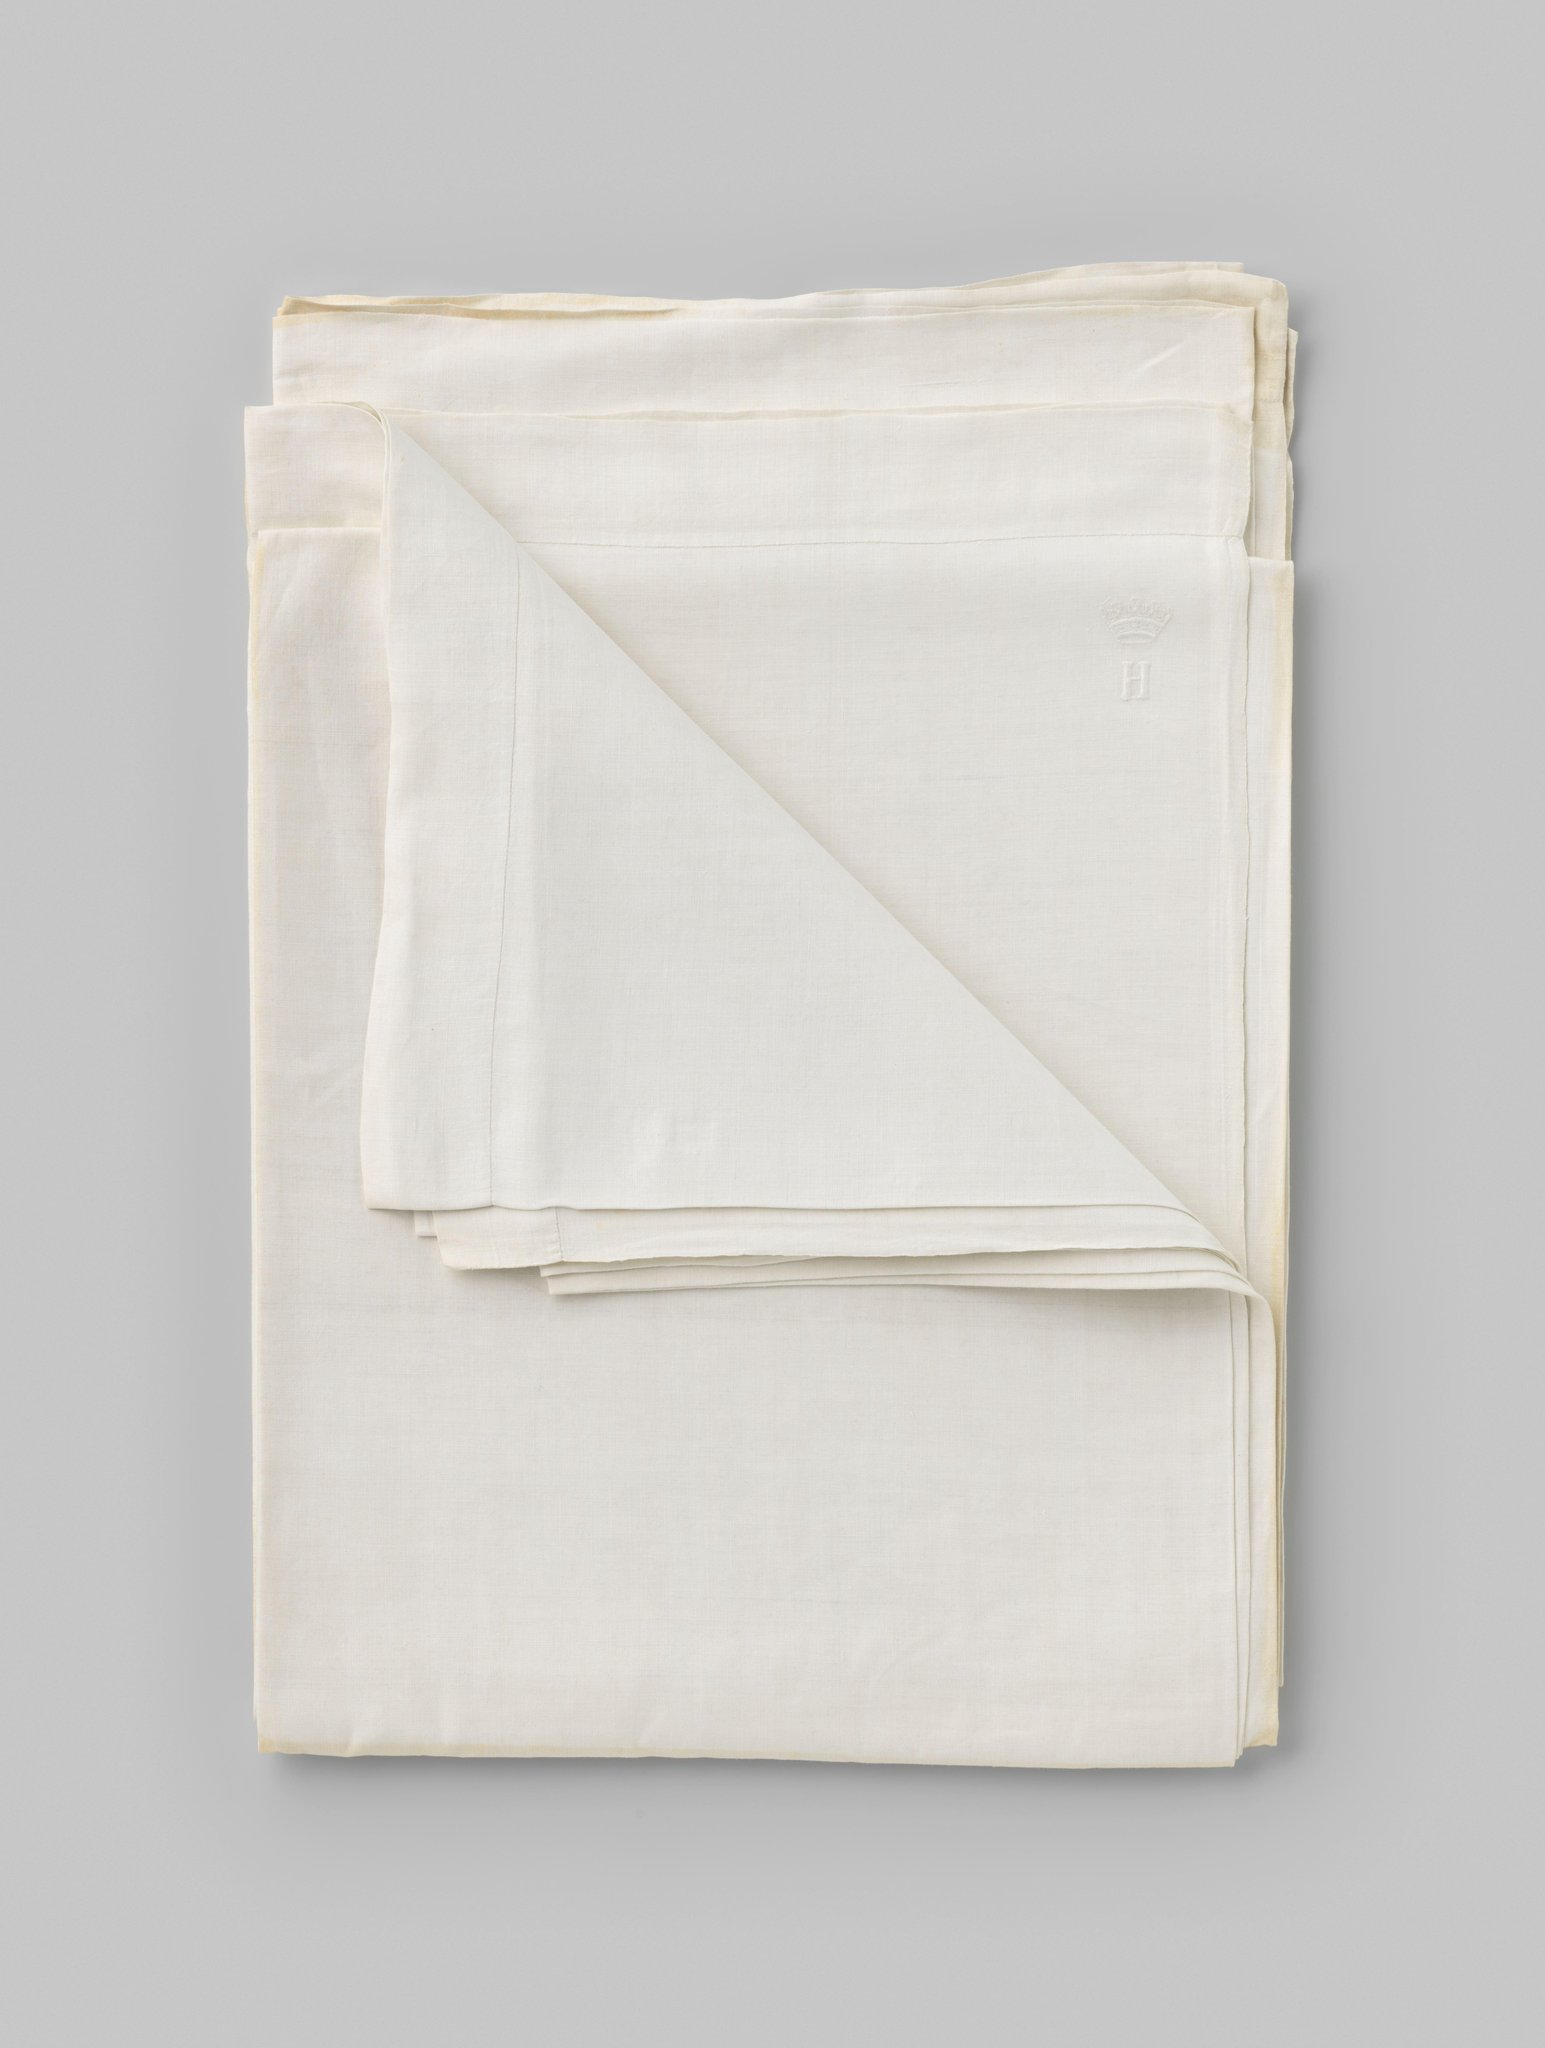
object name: beddenlaken, laken object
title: Laken. Merk: kroon H.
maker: Anonymous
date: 1890-1922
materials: linen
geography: northern netherlands